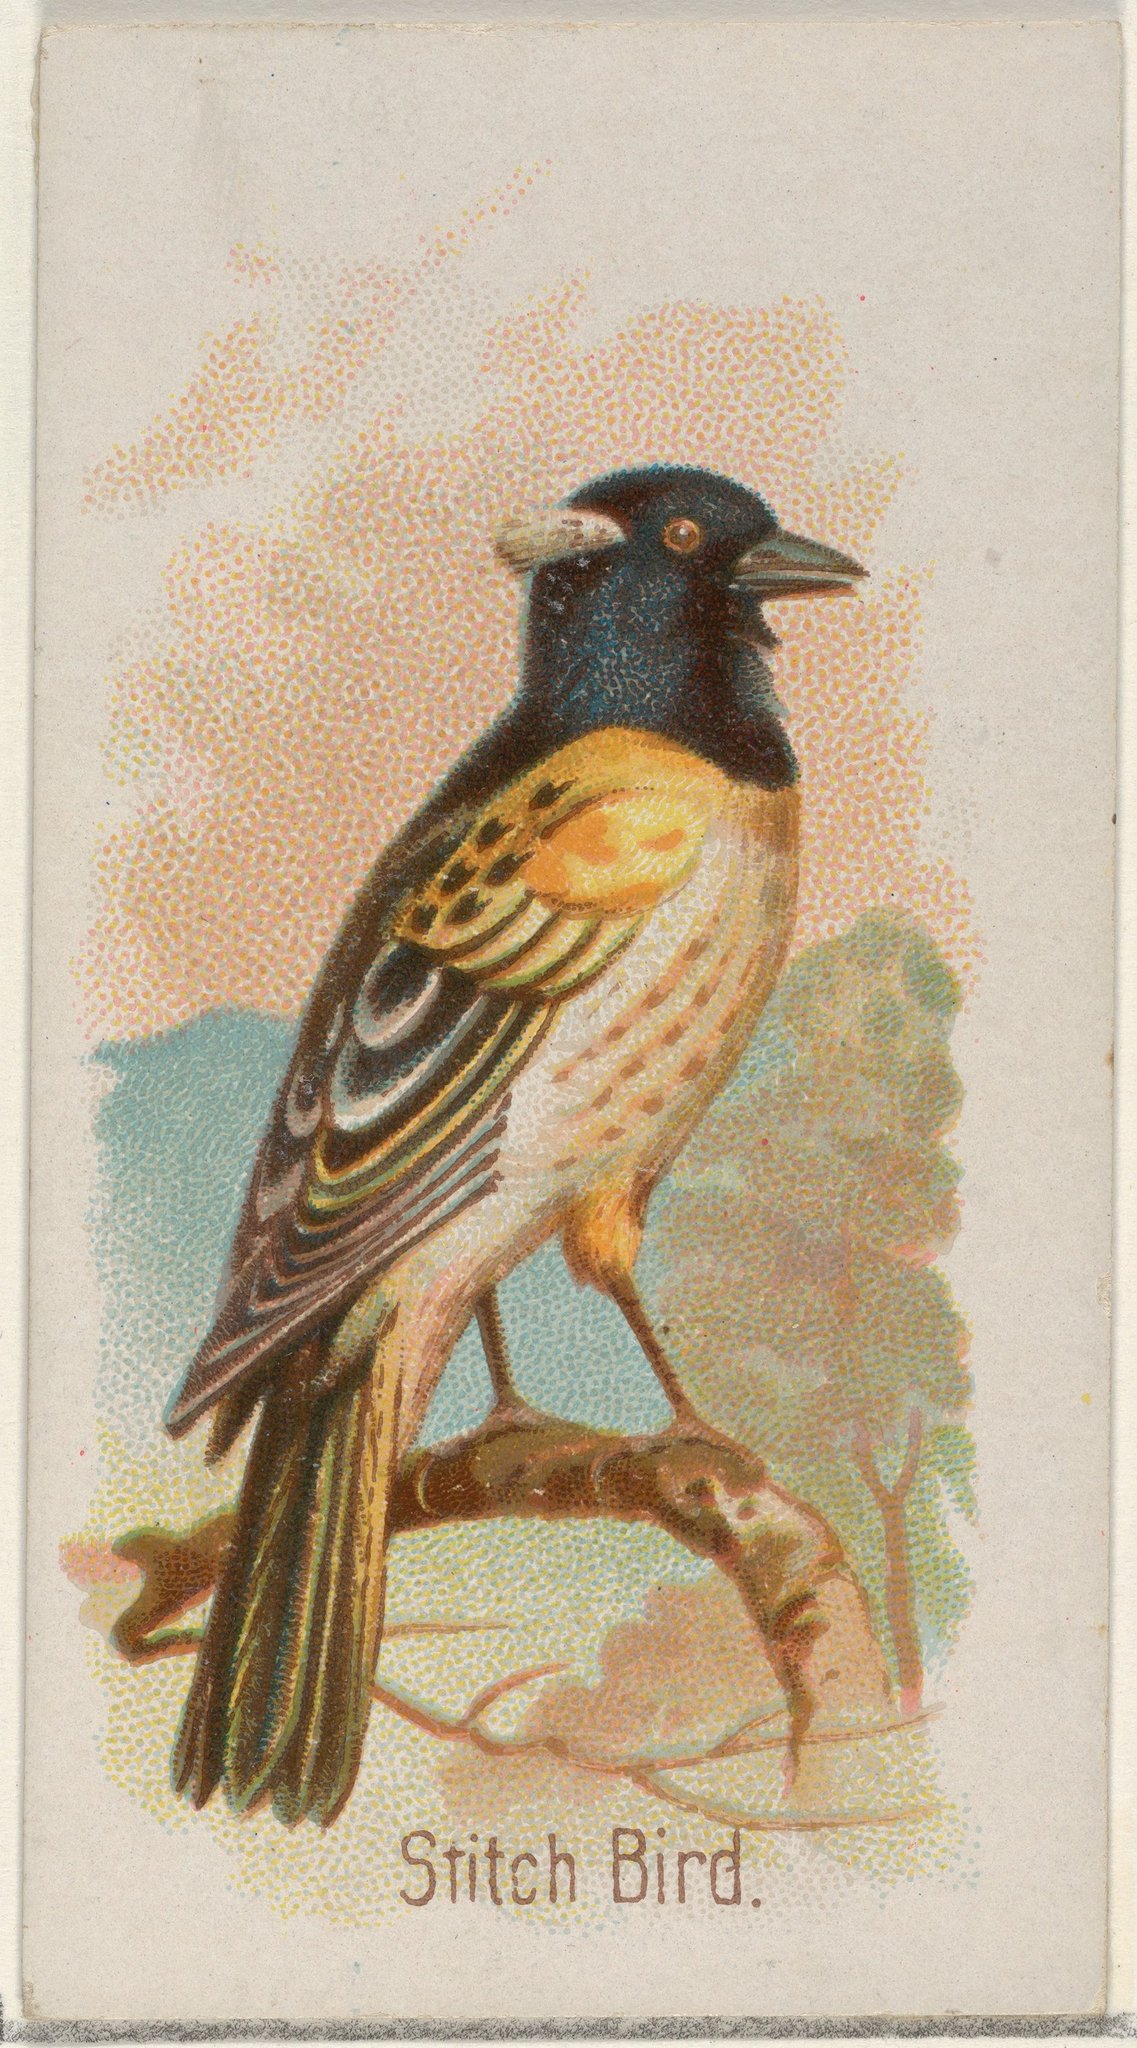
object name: print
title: Stitch Bird, from the Song Birds of the World series (N23) for Allen & Ginter Cigarettes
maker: allen & ginter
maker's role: publisher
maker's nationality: american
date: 1890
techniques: color lithograph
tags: birds